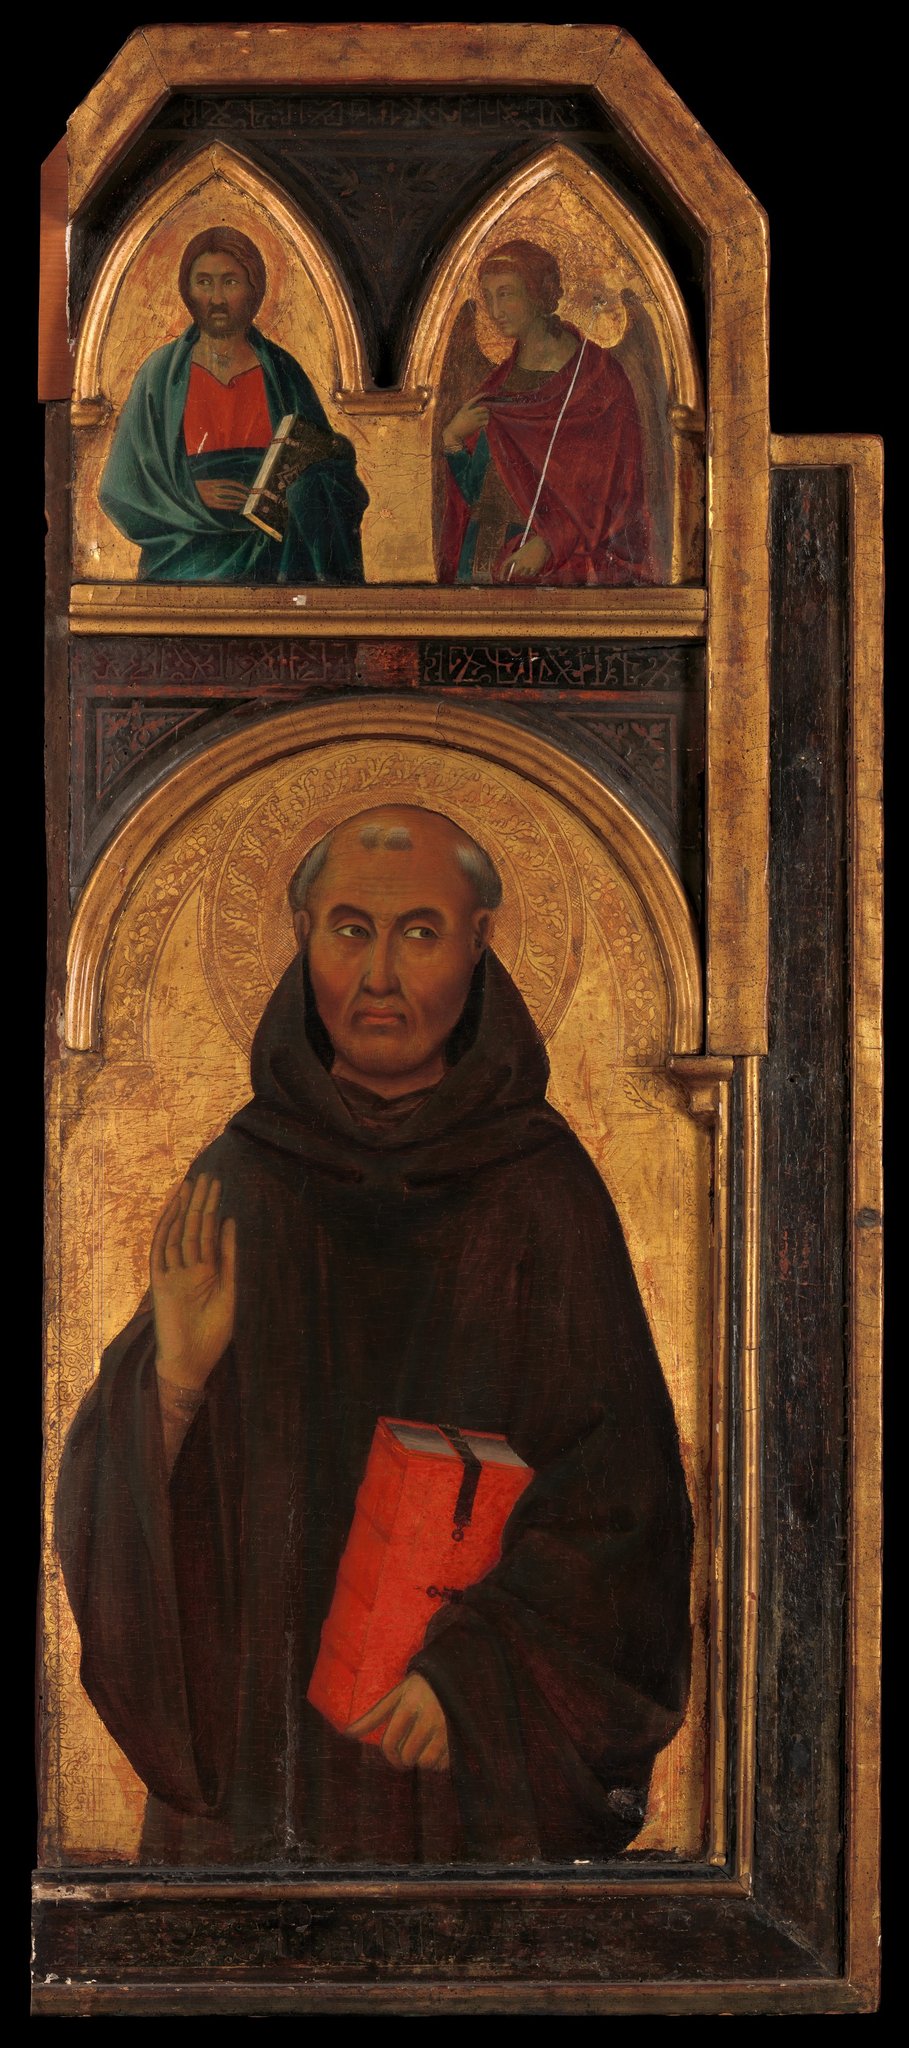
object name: painting, part of a polyptych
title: Saint Silvester Gozzolini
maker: segna di buonaventura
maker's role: artist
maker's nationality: italian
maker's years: 1298-1331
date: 1320-1329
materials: gold leaf, paint, wood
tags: men,angels,saints